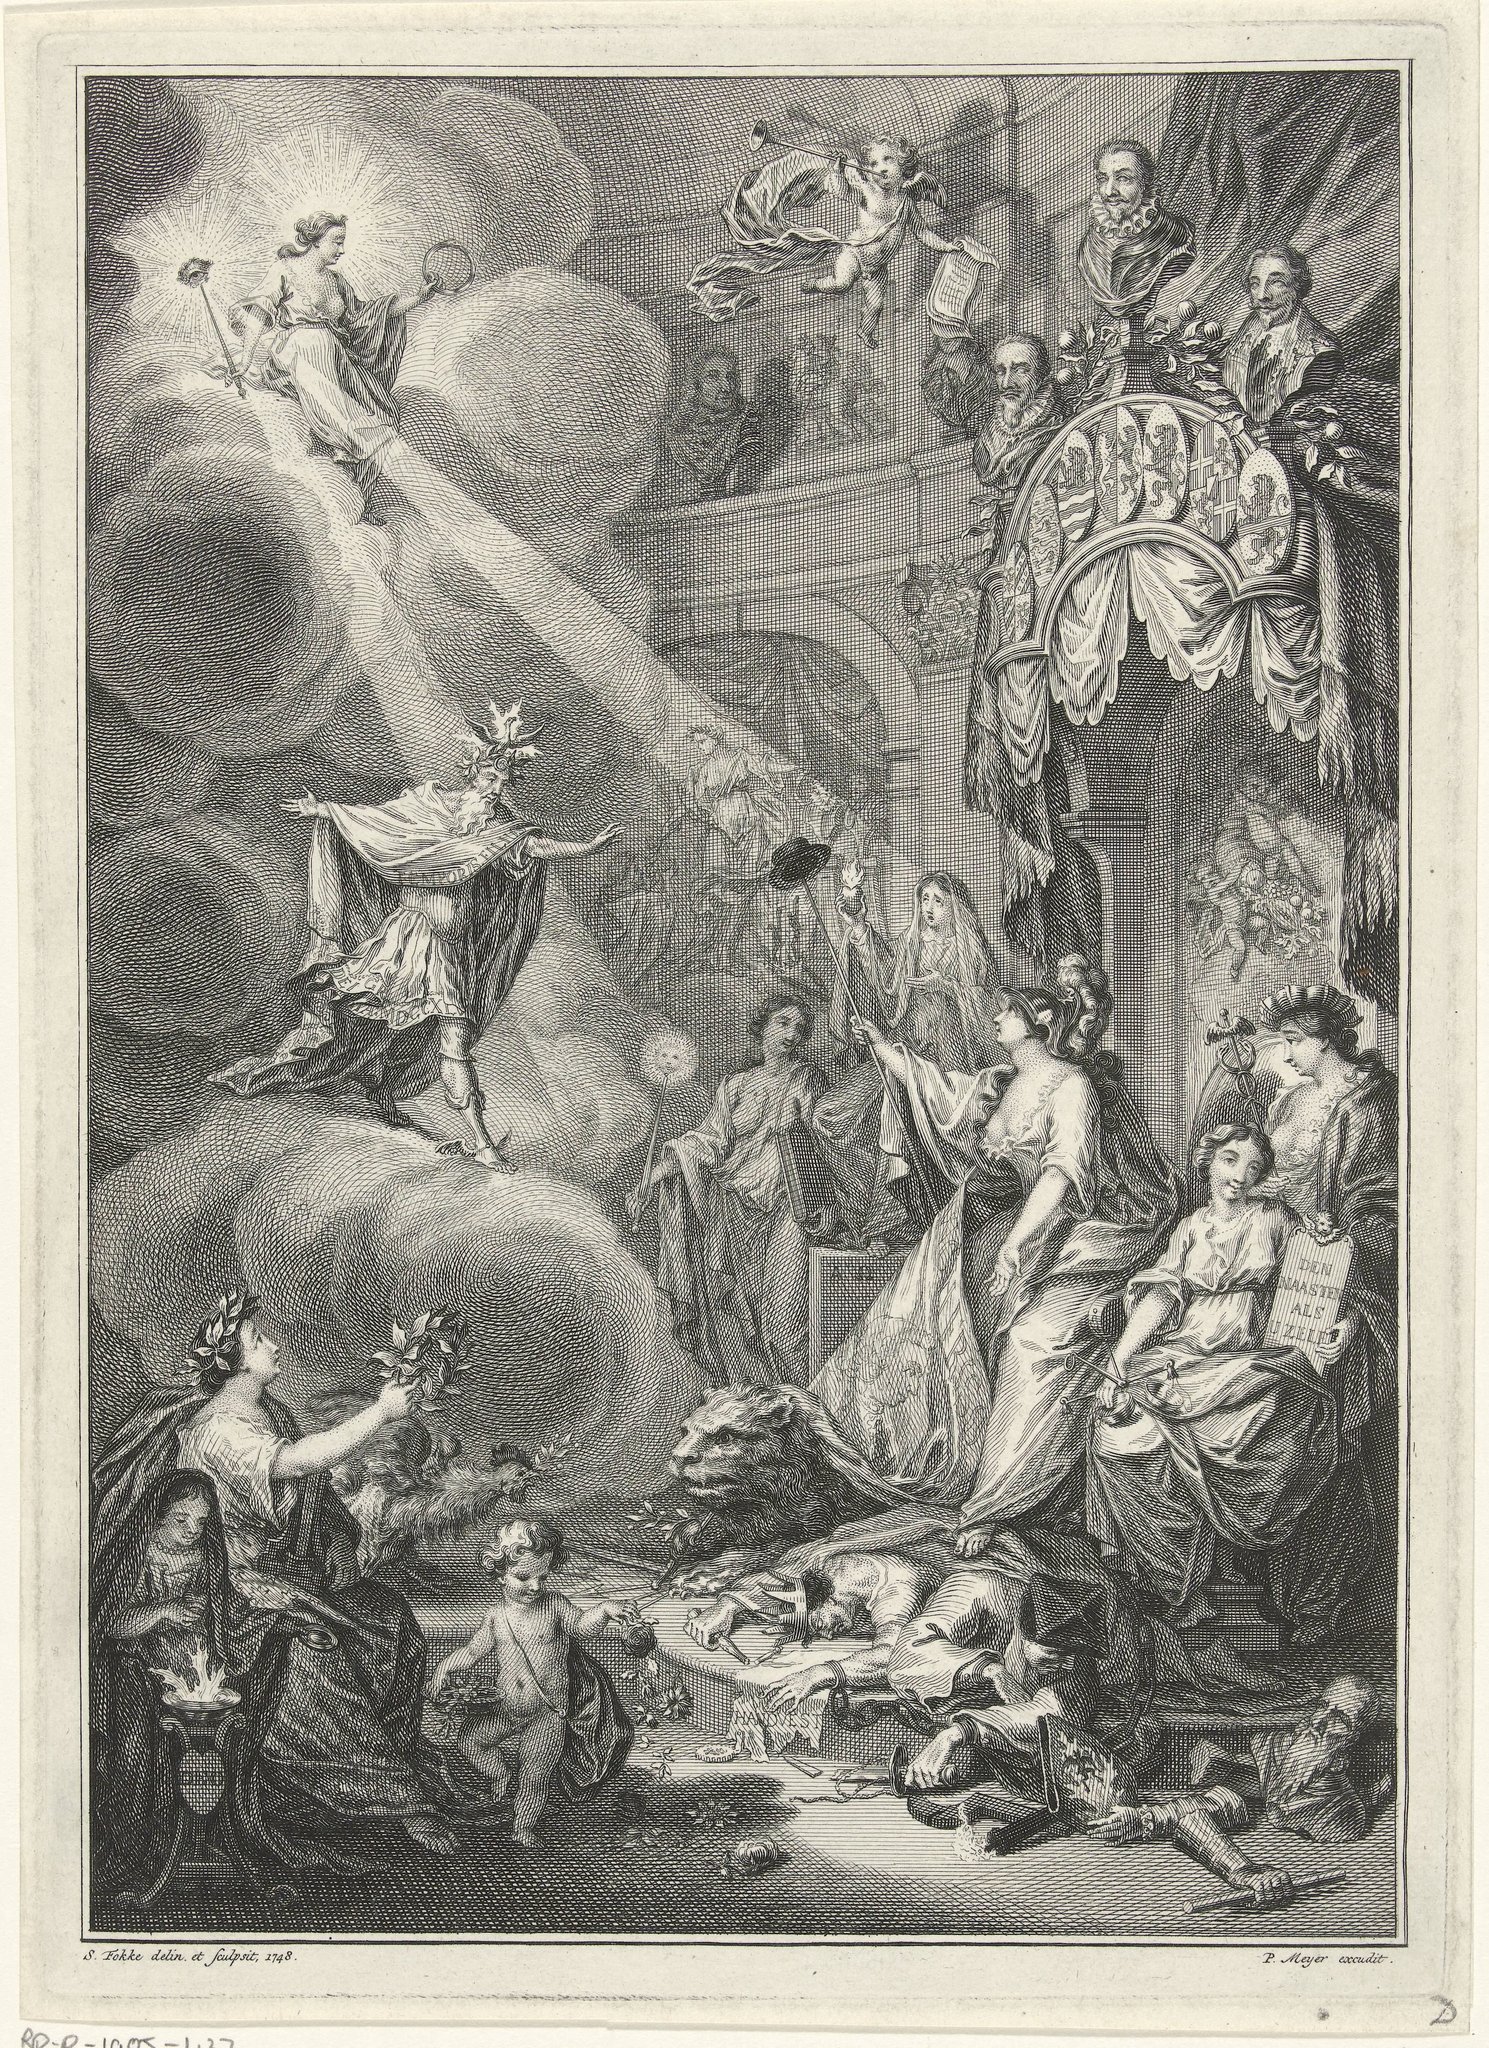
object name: print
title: Allegorie op het jubileum van Nederlands Vrijheid, 1748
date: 1748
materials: paper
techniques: engraving, etching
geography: amsterdam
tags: symbols, allegories of peace, 'pax'; 'pace' (ripa), freedom, liberty; 'libertà' (ripa)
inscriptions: collector's mark: Lugt 2228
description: Allegorie op het 100-jarig jubileum van Nederlands Vrijheid, 1648-1748. De personificatie van Nederlands Vrijheid, afgebeeld met hoed op stok, de Nederlandse leeuw en vaandel van prins Willem IV, ontvangt de personificatie van de Eeuw die uit de wolken is afgedaald. Boven de troon staan bustes van de stadhouders, aan de voeten van de Vrijheid ligt de tijdens de opstand verslagen vijand: de katholieke kerk.